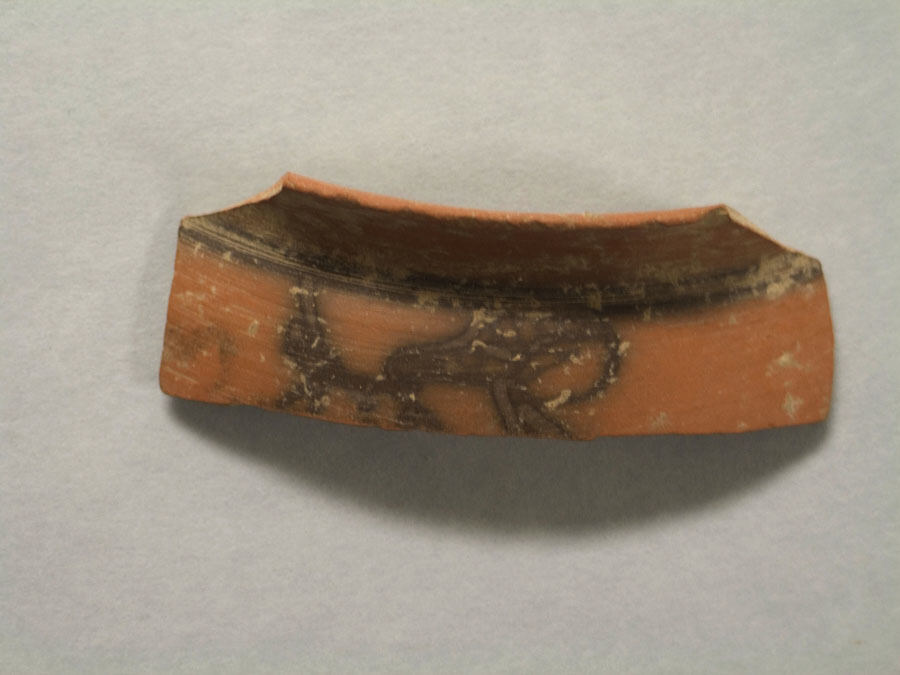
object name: shard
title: Shard: Neckpiece with Figure Looking Back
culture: pakistani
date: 301-500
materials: terracotta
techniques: painting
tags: gandhara